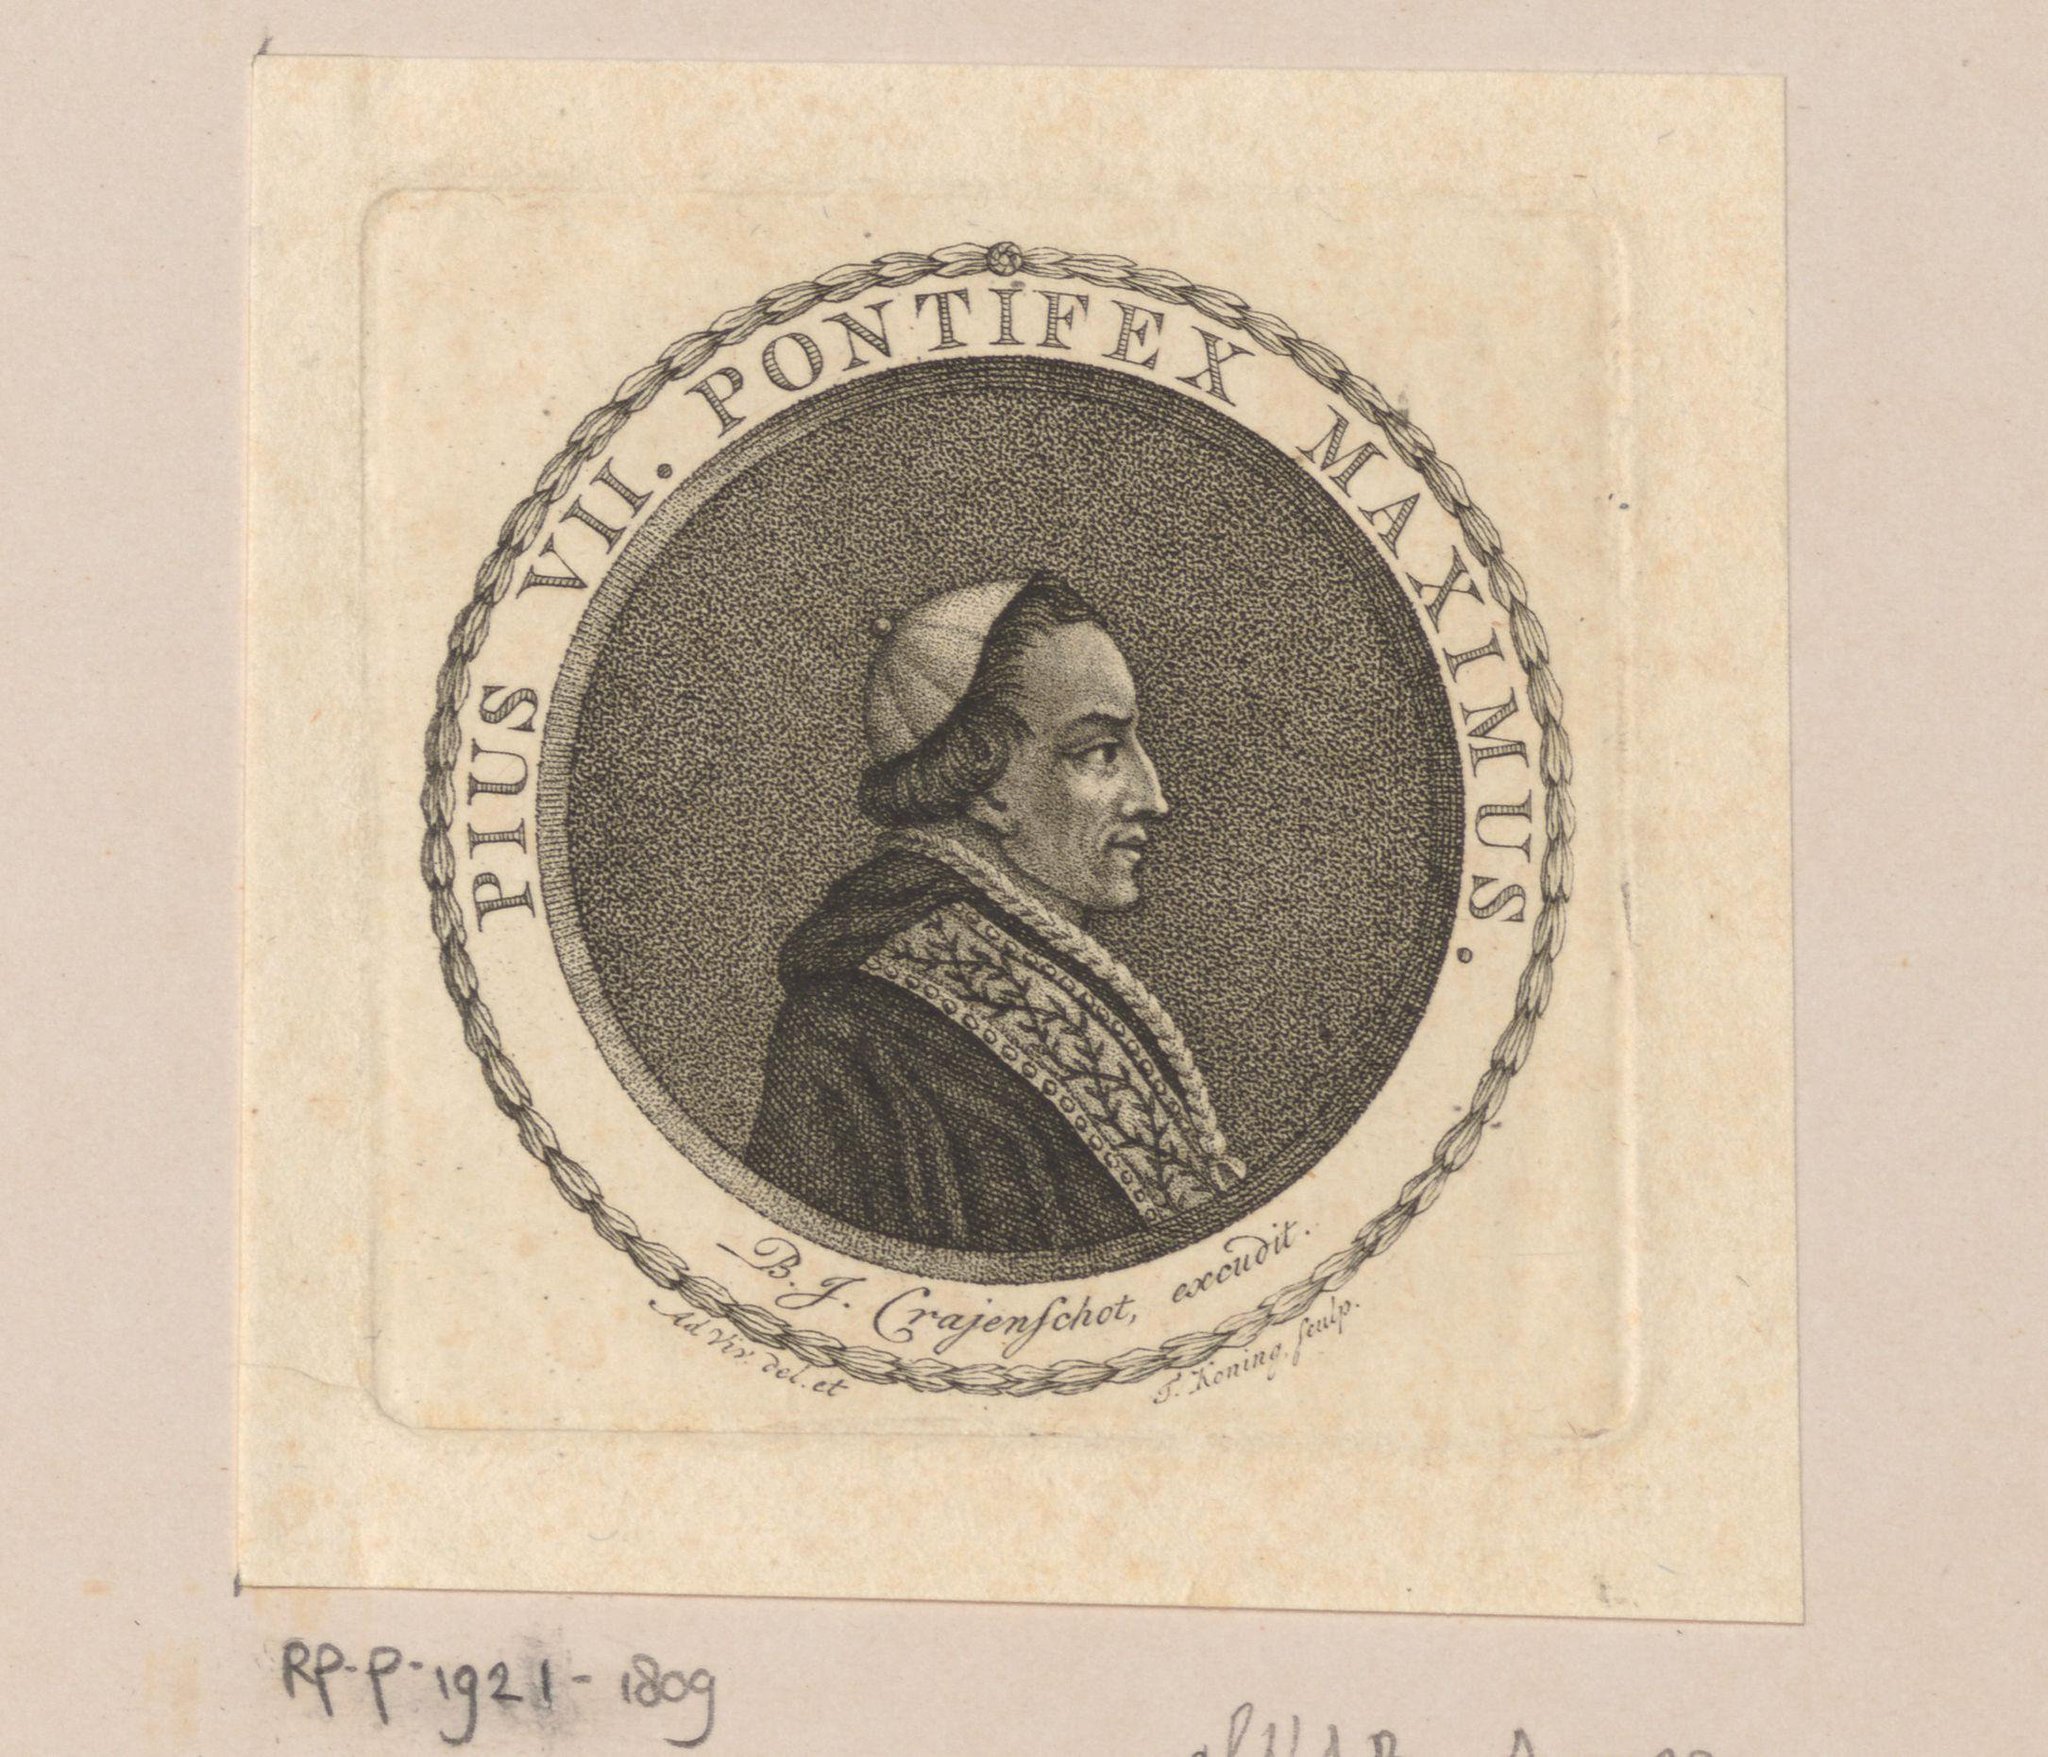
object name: print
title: Portret van paus Pius VII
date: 1800-1829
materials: paper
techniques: engraving, etching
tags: clergyman, pius vii, historical persons, pope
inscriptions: collector's mark: Lugt 2233